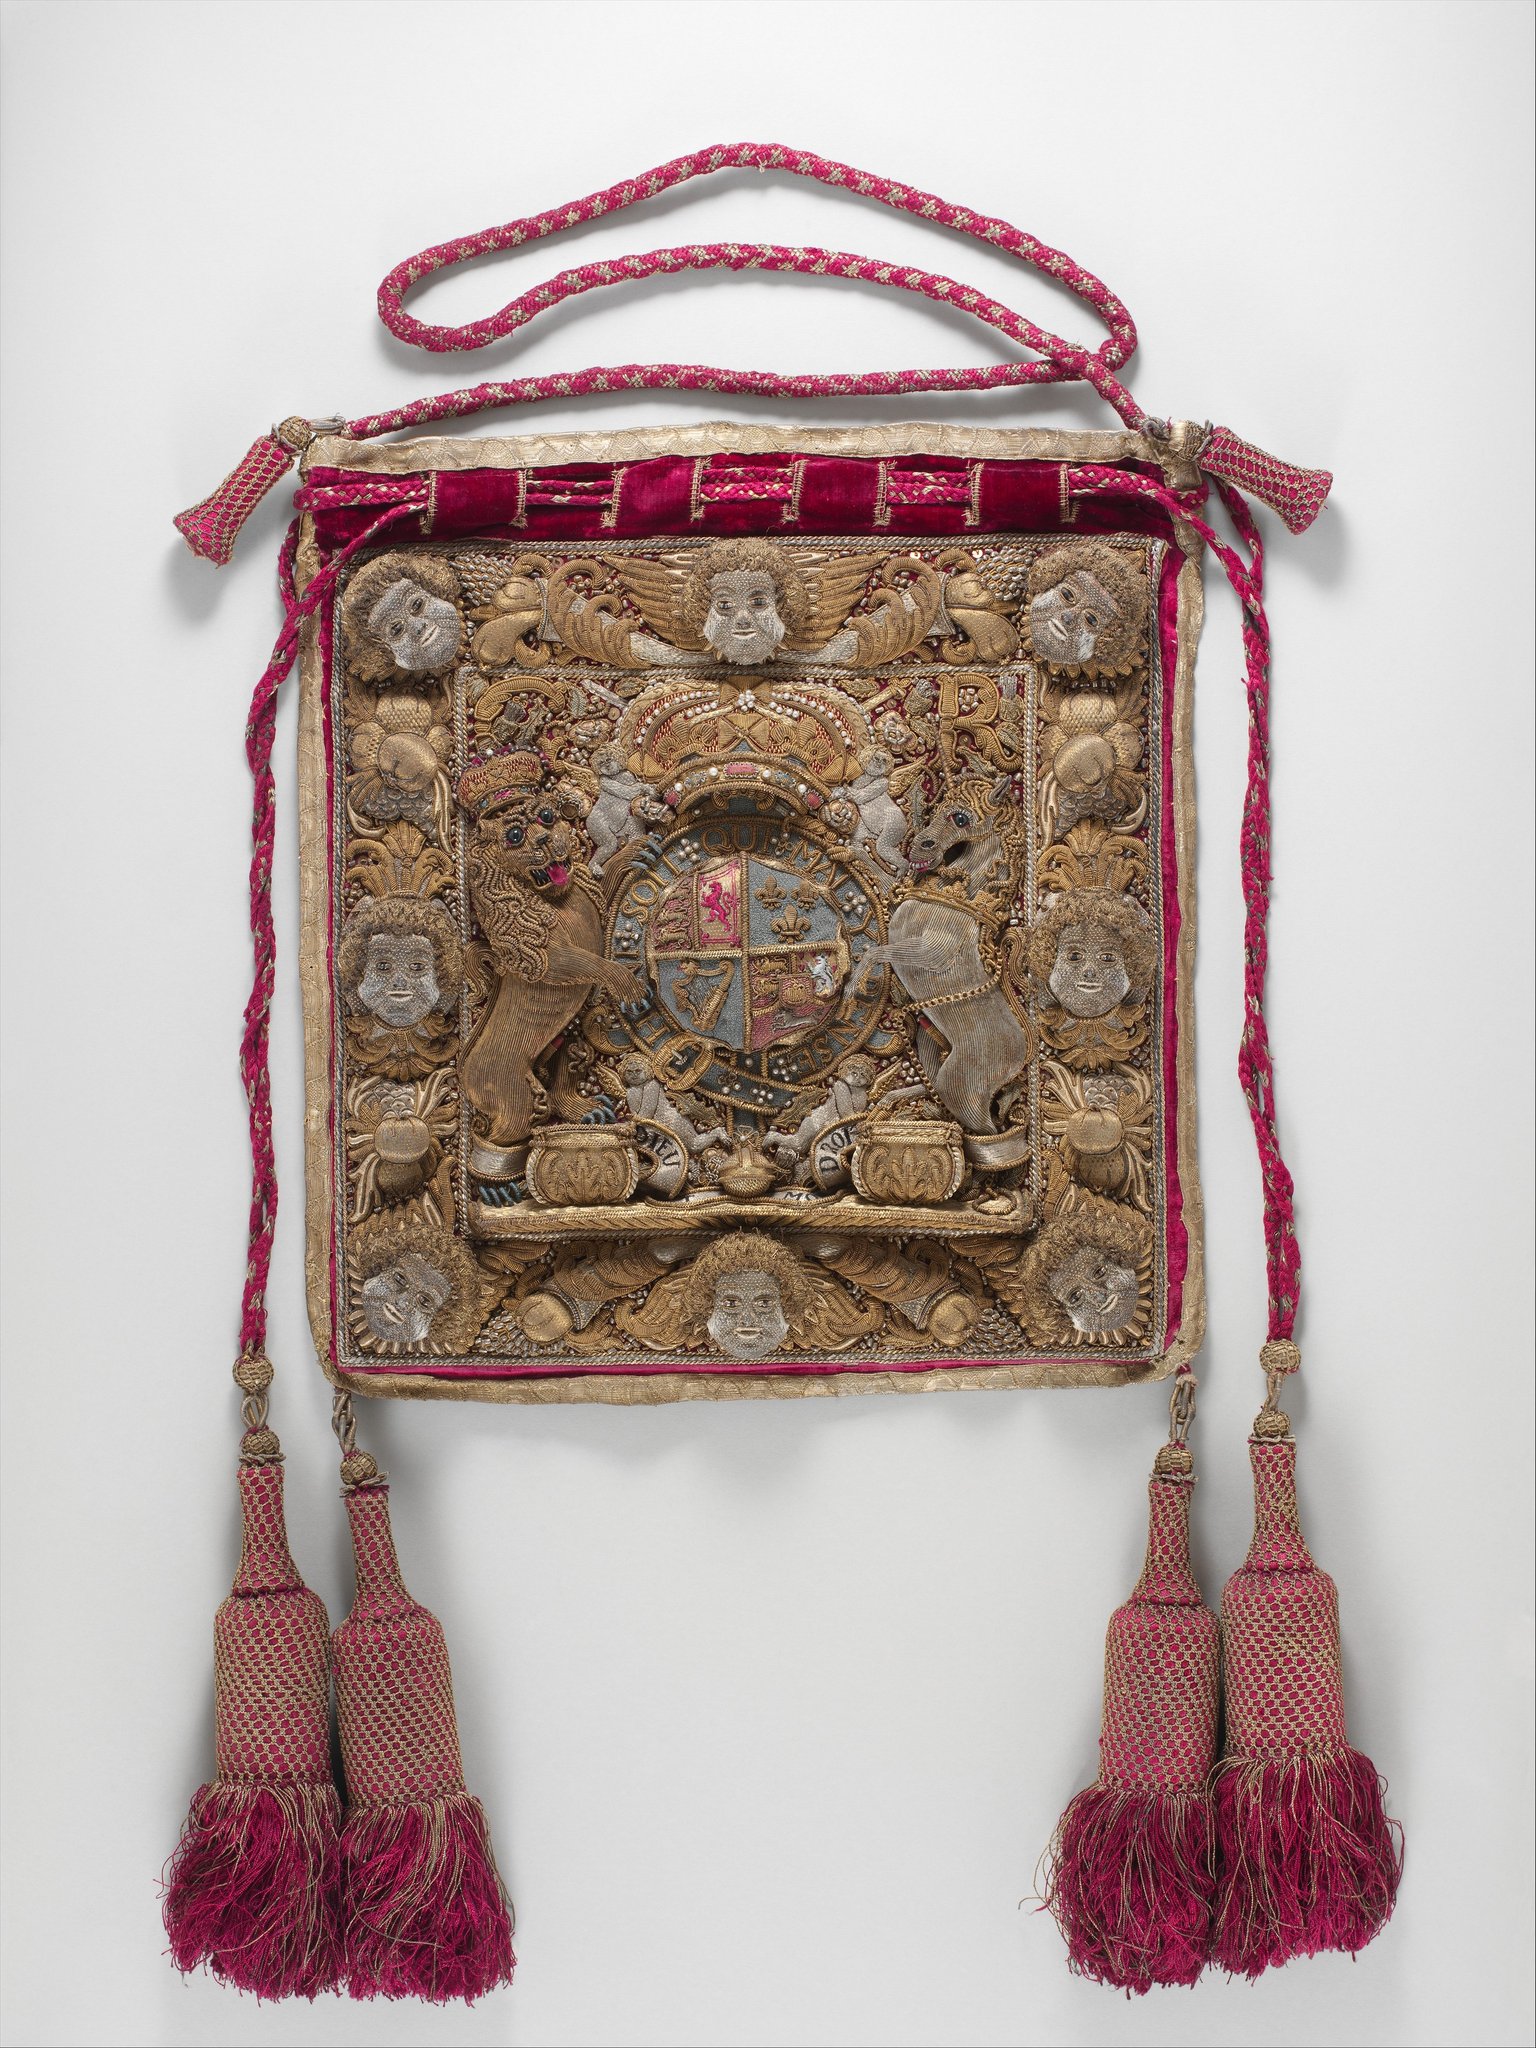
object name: burse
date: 1714-1727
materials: garnet, metal thread, pearl, silk, velvet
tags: faces,horses,lions,coat of arms